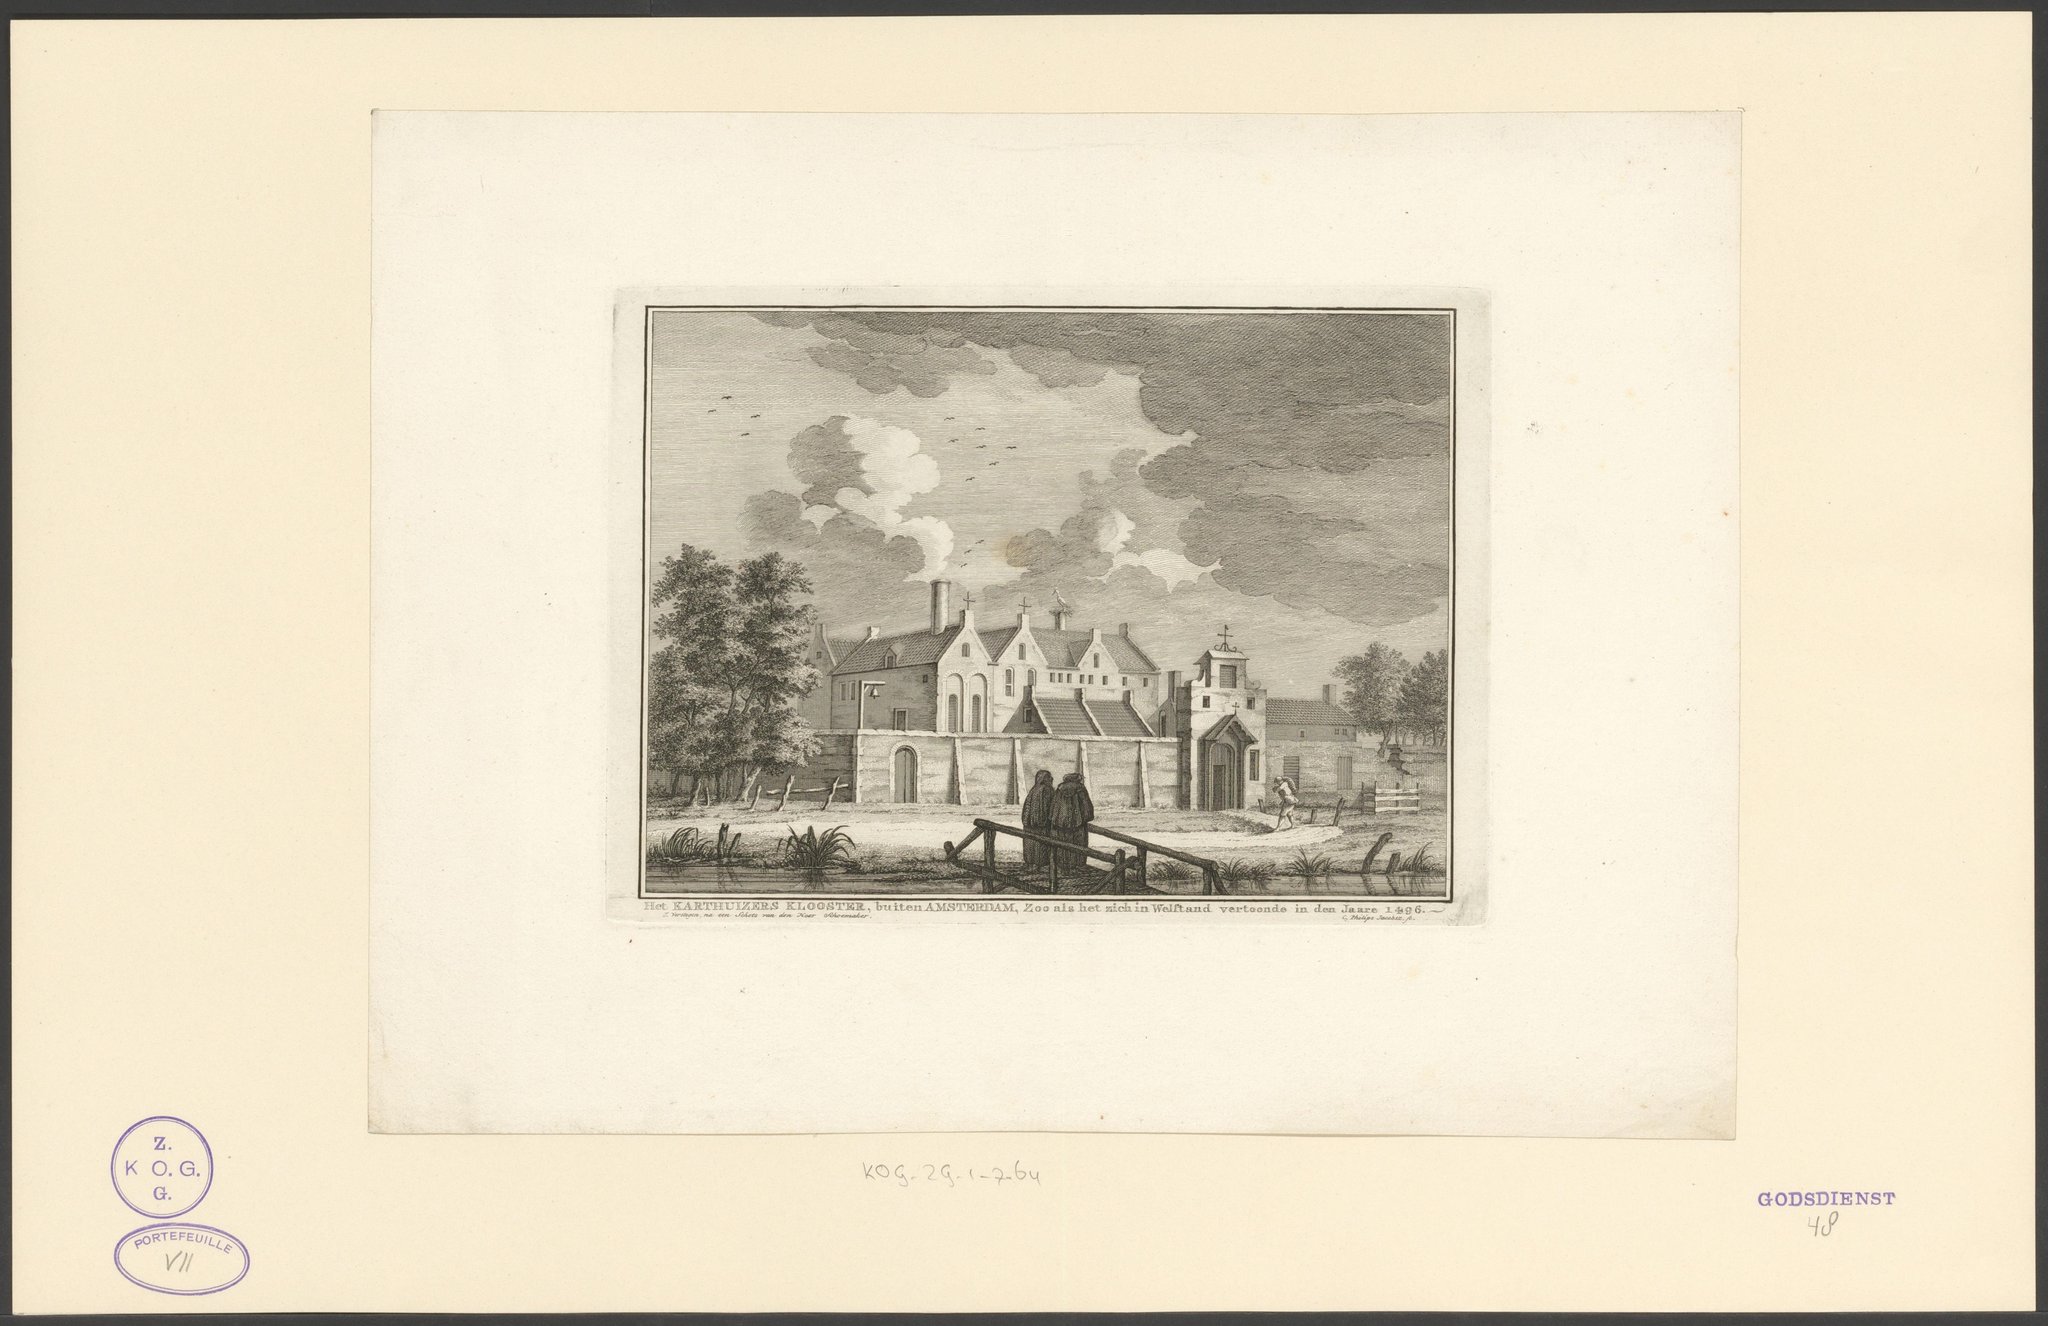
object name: print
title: Het Karthuizers Klooster, buiten Amsterdam, Zoo als het zich in Welstand vertoonde in den Jaare 1496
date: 1752-1789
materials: paper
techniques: engraving, etching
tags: shore-birds and wading-birds: stork, nun(s), cloisters ~ monastery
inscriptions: collector's mark: Lugt 1641, stamp, stamp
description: Onderwerpsrubrieken binnen de Atlas Zeden en Gewoonten: Godsdienst, Roomsch-Katholieken, Kloosters.